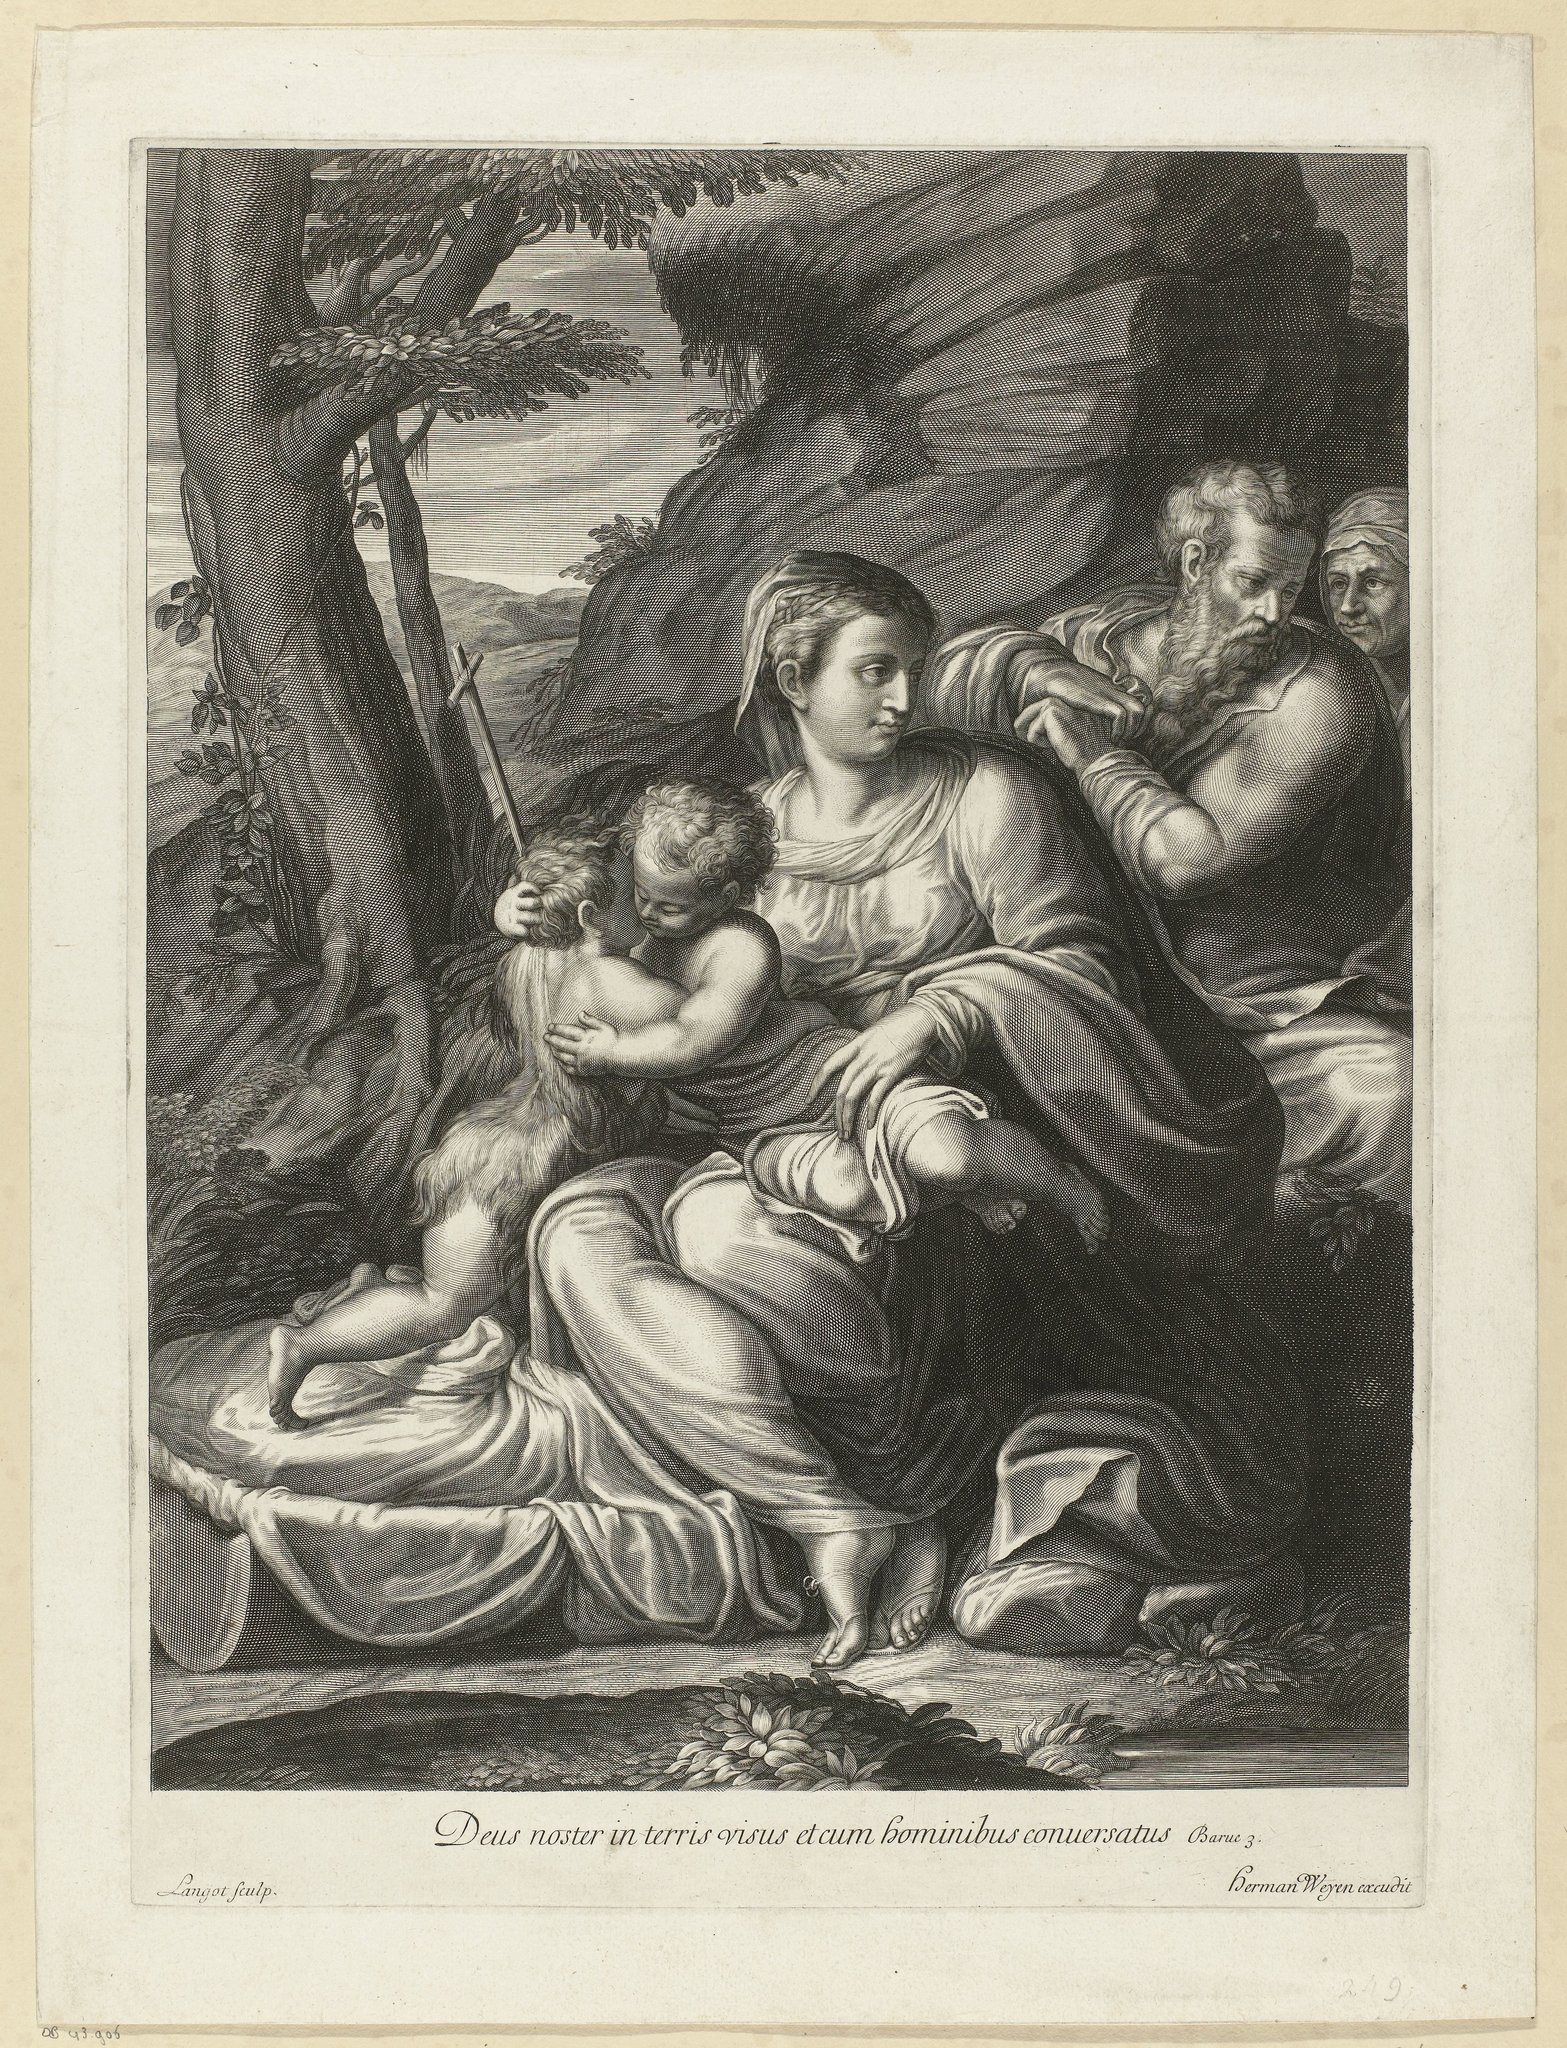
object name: print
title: Heilige Familie met Johannes en Elisabeth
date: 1600-1672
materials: paper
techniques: engraving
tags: holy family, and derived representations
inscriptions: collector's mark: Lugt 240